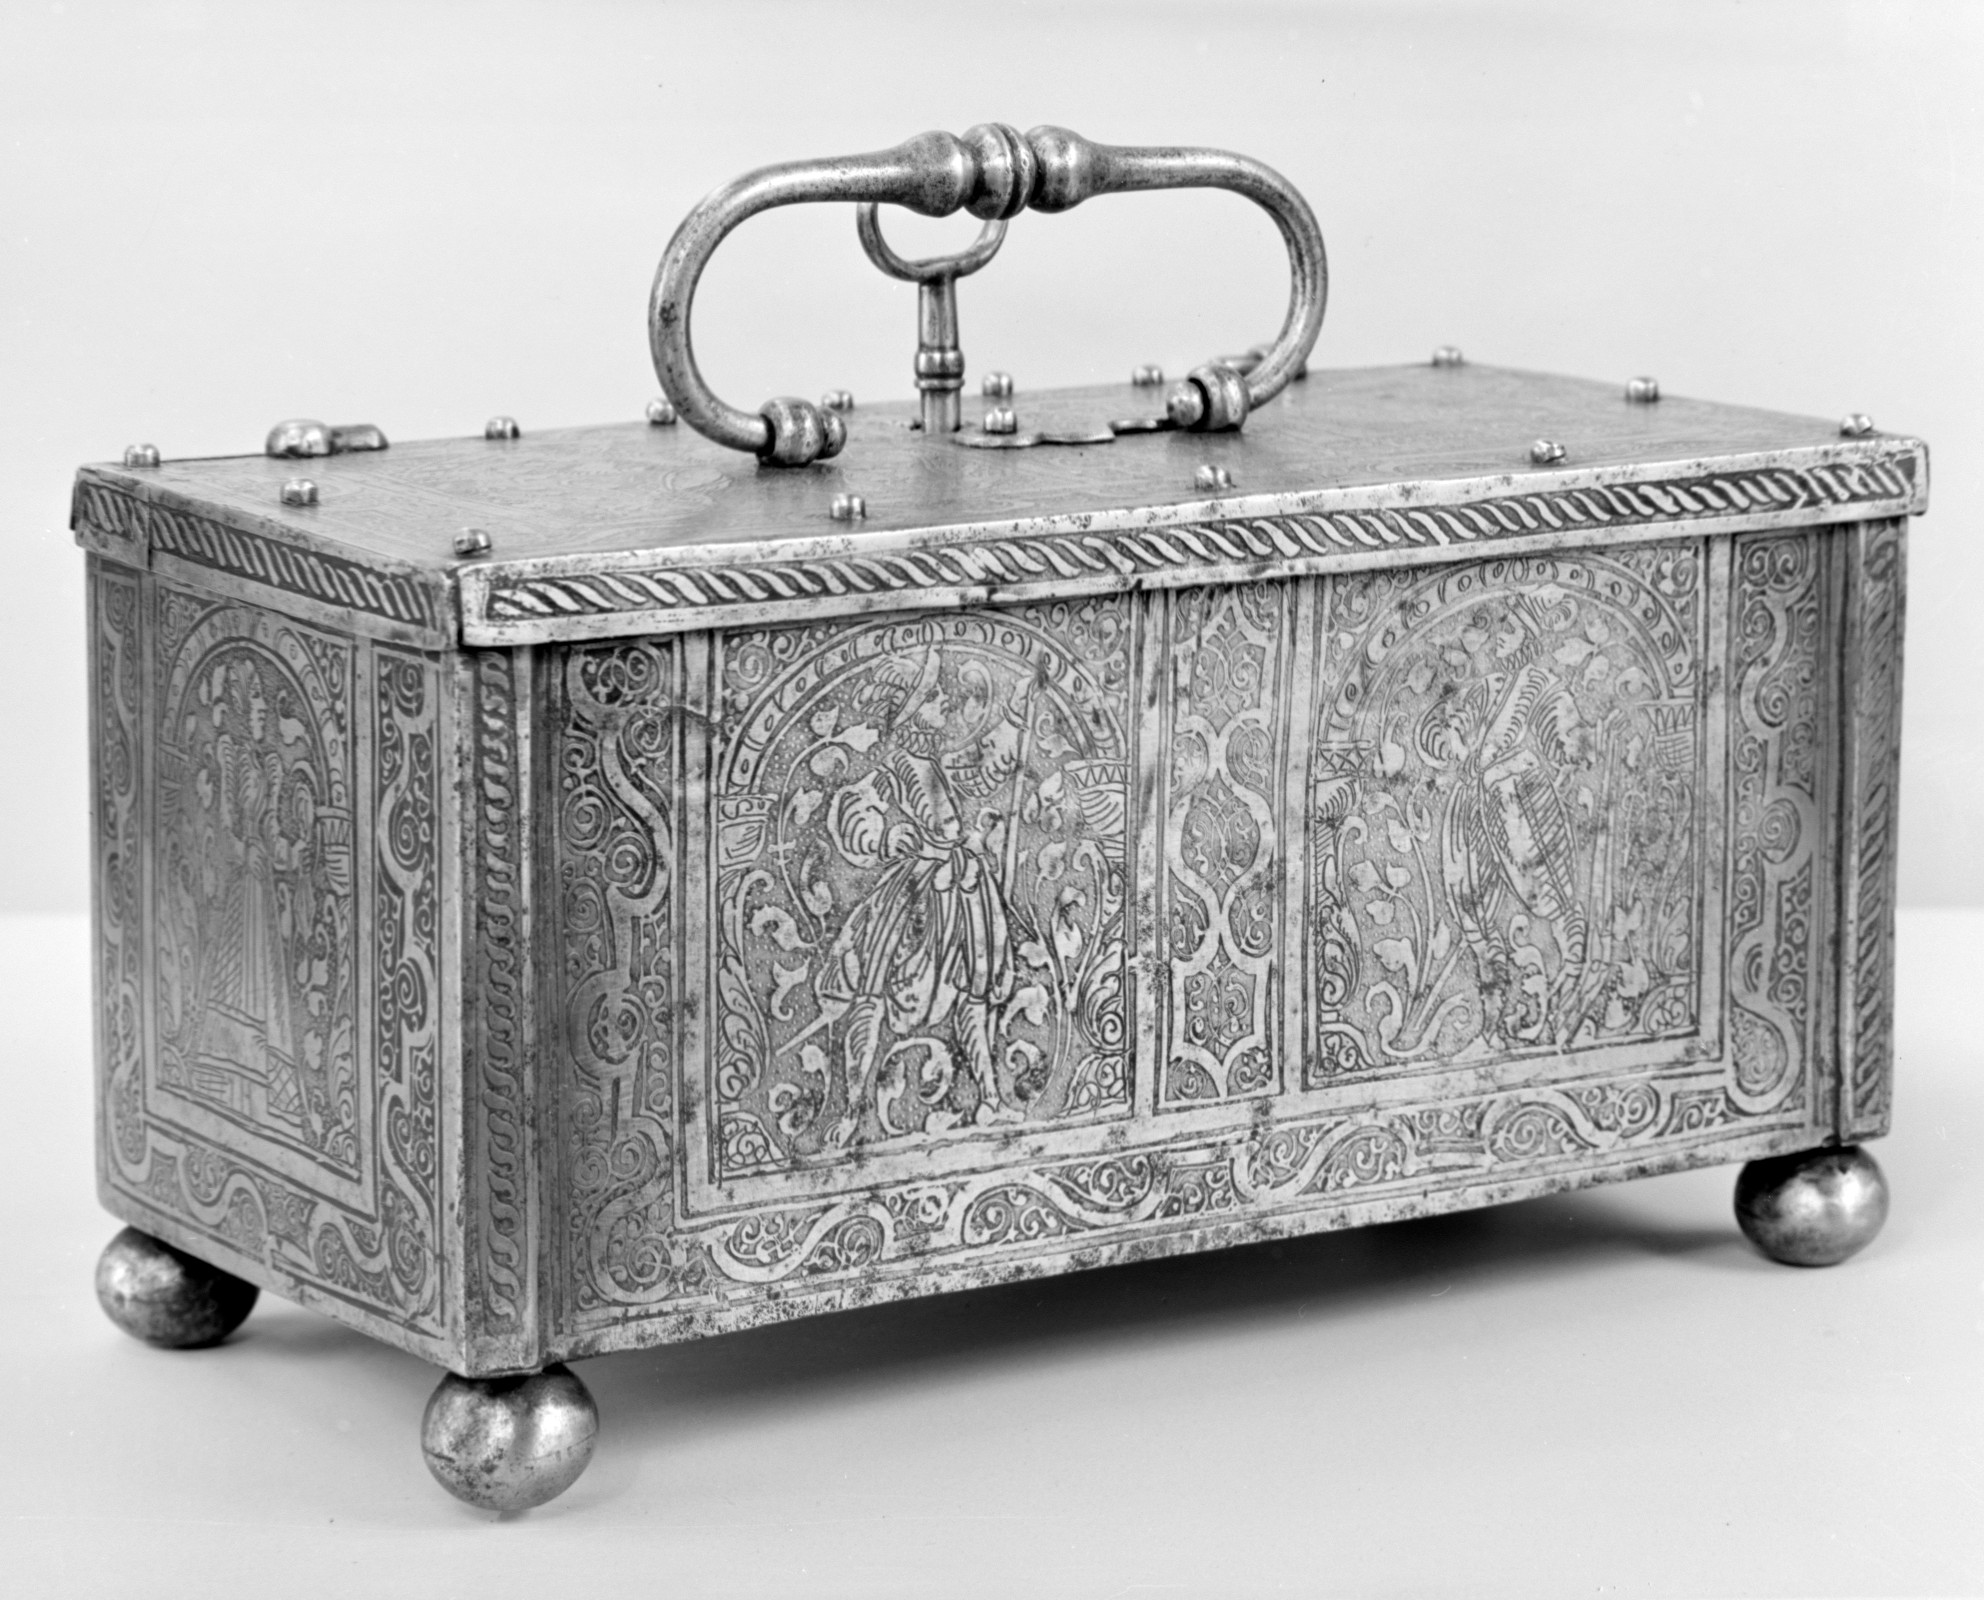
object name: coffer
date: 1501-1600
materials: steel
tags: men